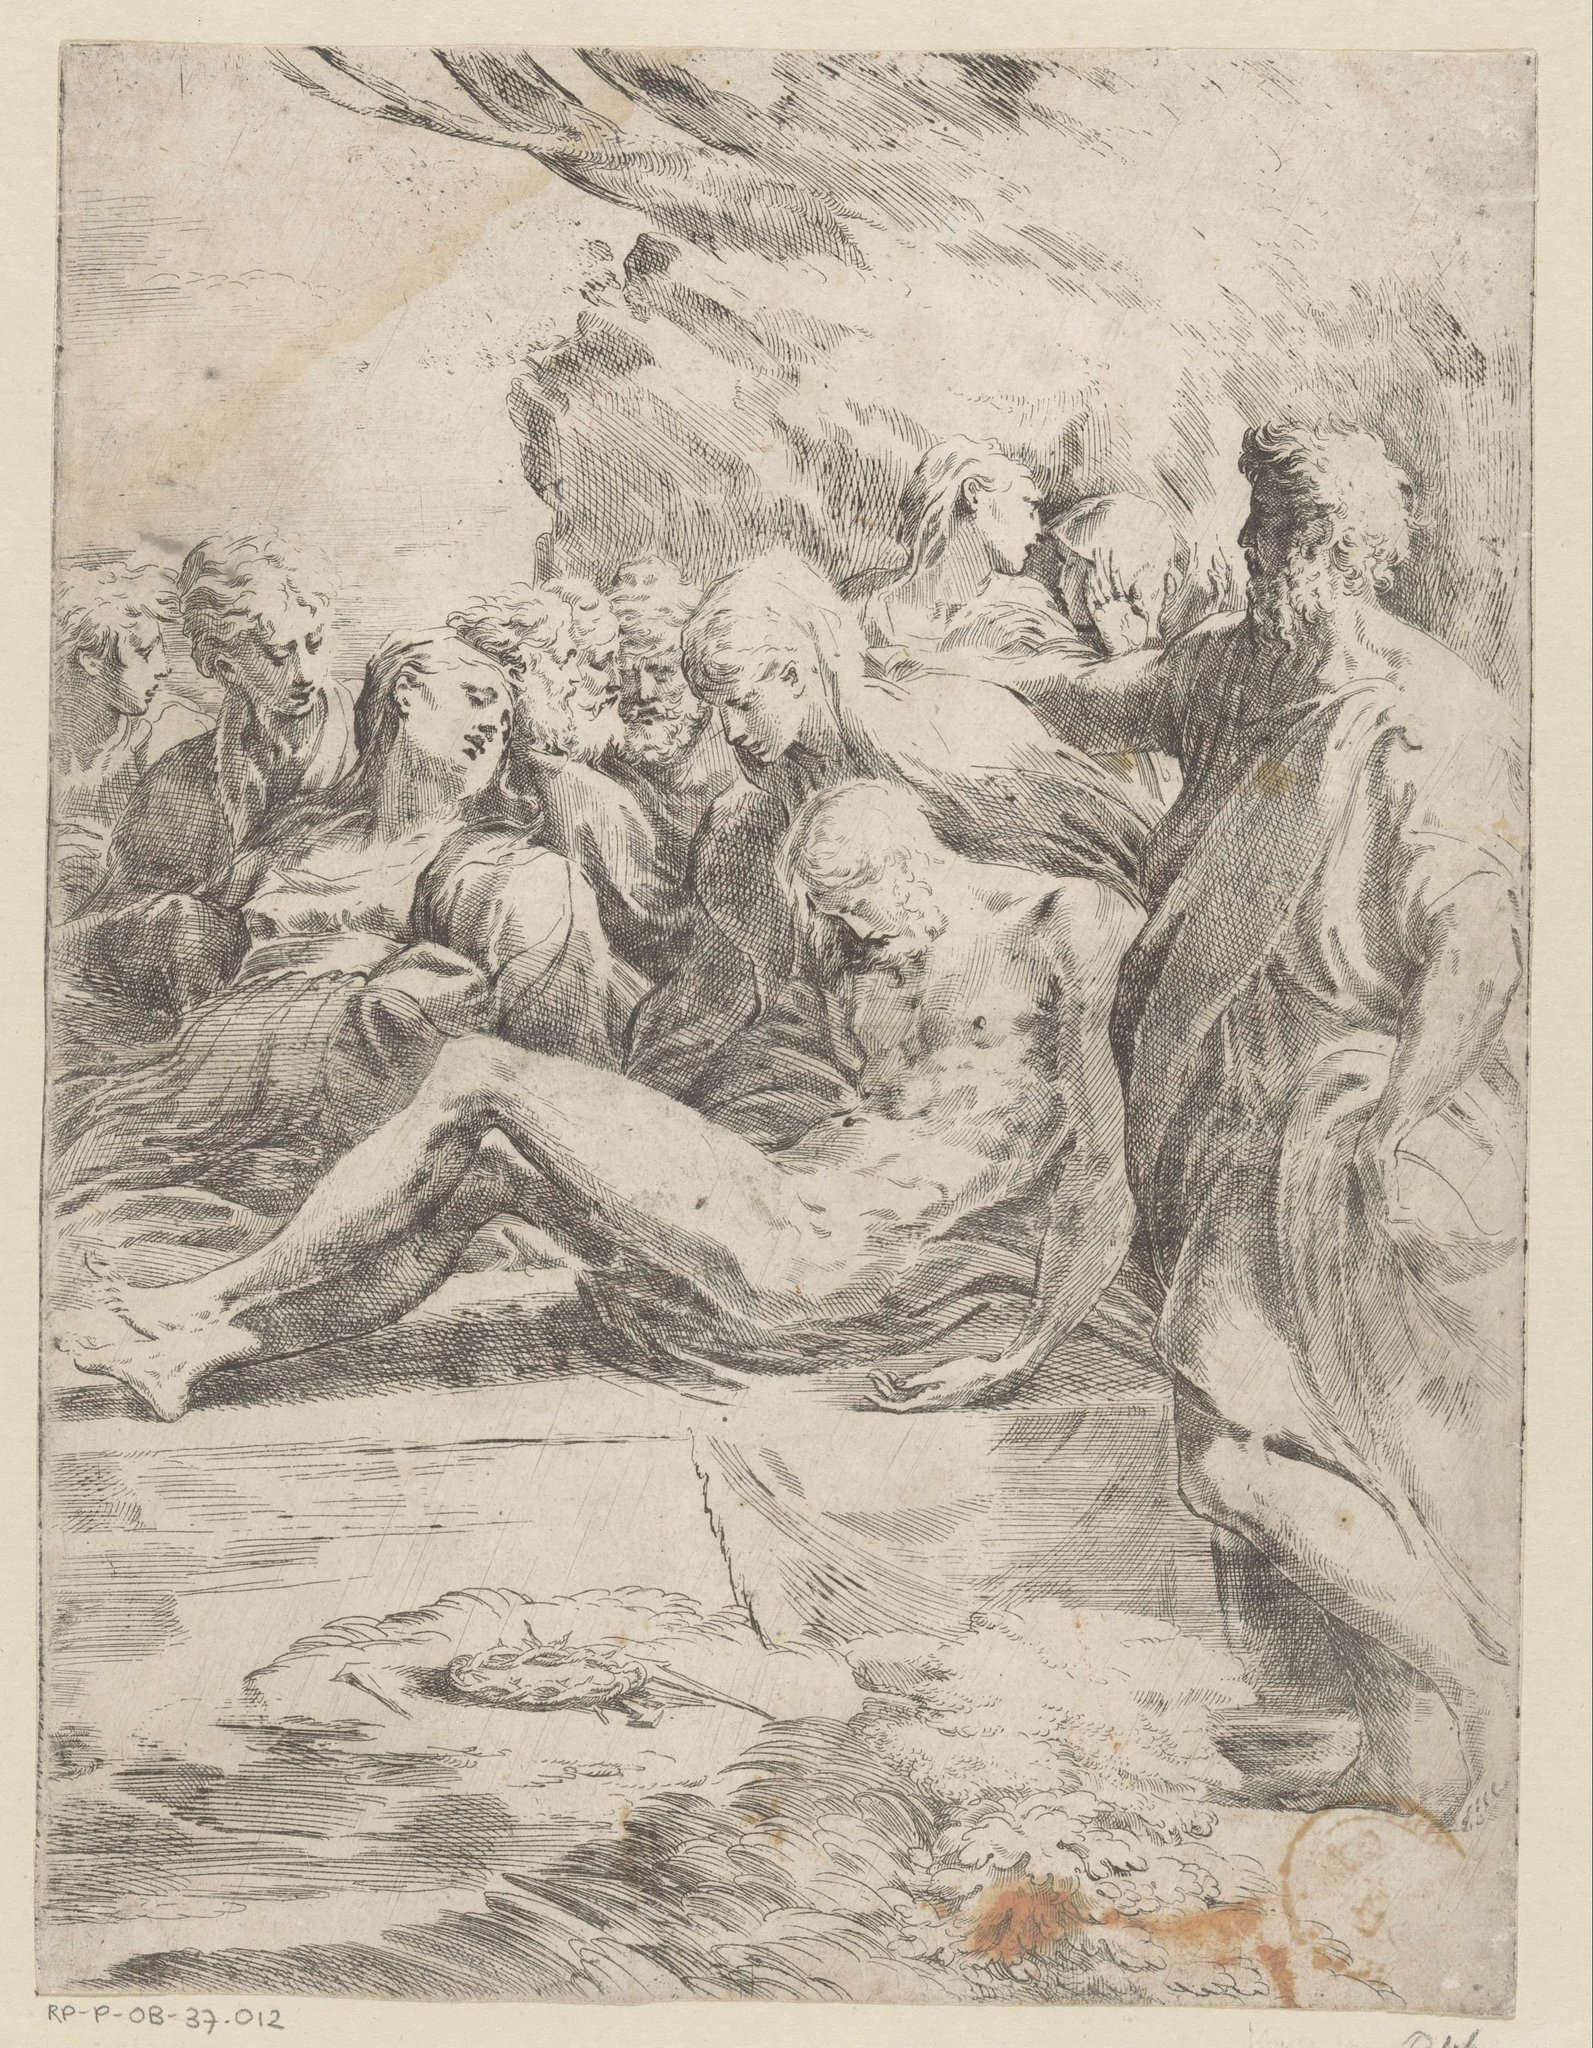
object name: print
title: Graflegging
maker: guido reni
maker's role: draughtsman, painter, print maker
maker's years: 1575-1642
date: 1585-1642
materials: paper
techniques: etching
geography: italy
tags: christ's entombment (possibly by angels)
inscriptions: collector's mark: Lugt 240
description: Het lichaam van Christus is neergelegd op een stenen blok. Rond het lichaam staan treurende mannen en vrouwen.